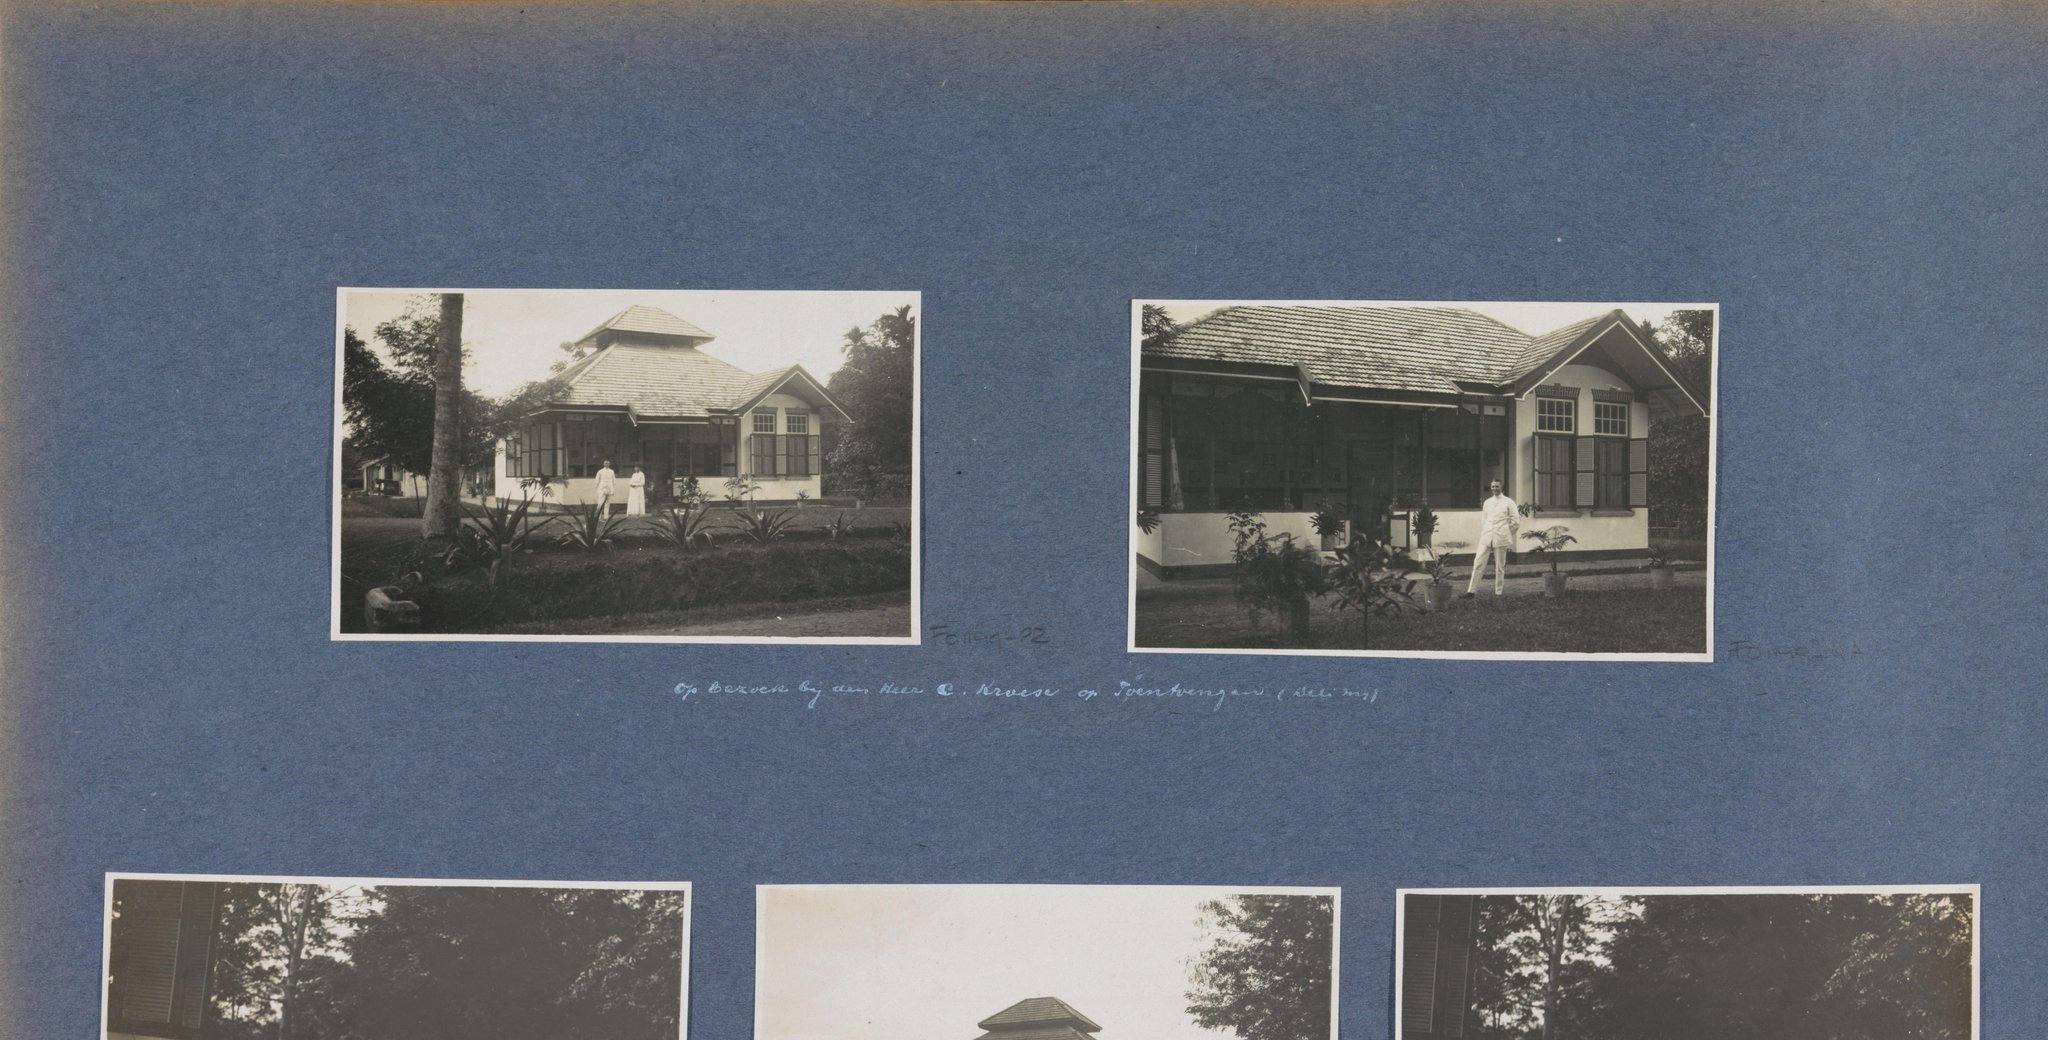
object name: photograph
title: Kind van de familie Jelgerhuis-Swildens in een tuinstoel te Pandjang Djati op Sumatra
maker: Anonymous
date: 1900-1920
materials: paper, photographic support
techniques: gelatin silver print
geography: sumatra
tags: garden, child, sumatra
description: Onderdeel van reisalbum met foto's van bedrijvigheid en bezienswaardigheden op Sumatra en Java en van de reis naar en van Nederlands-Indië.